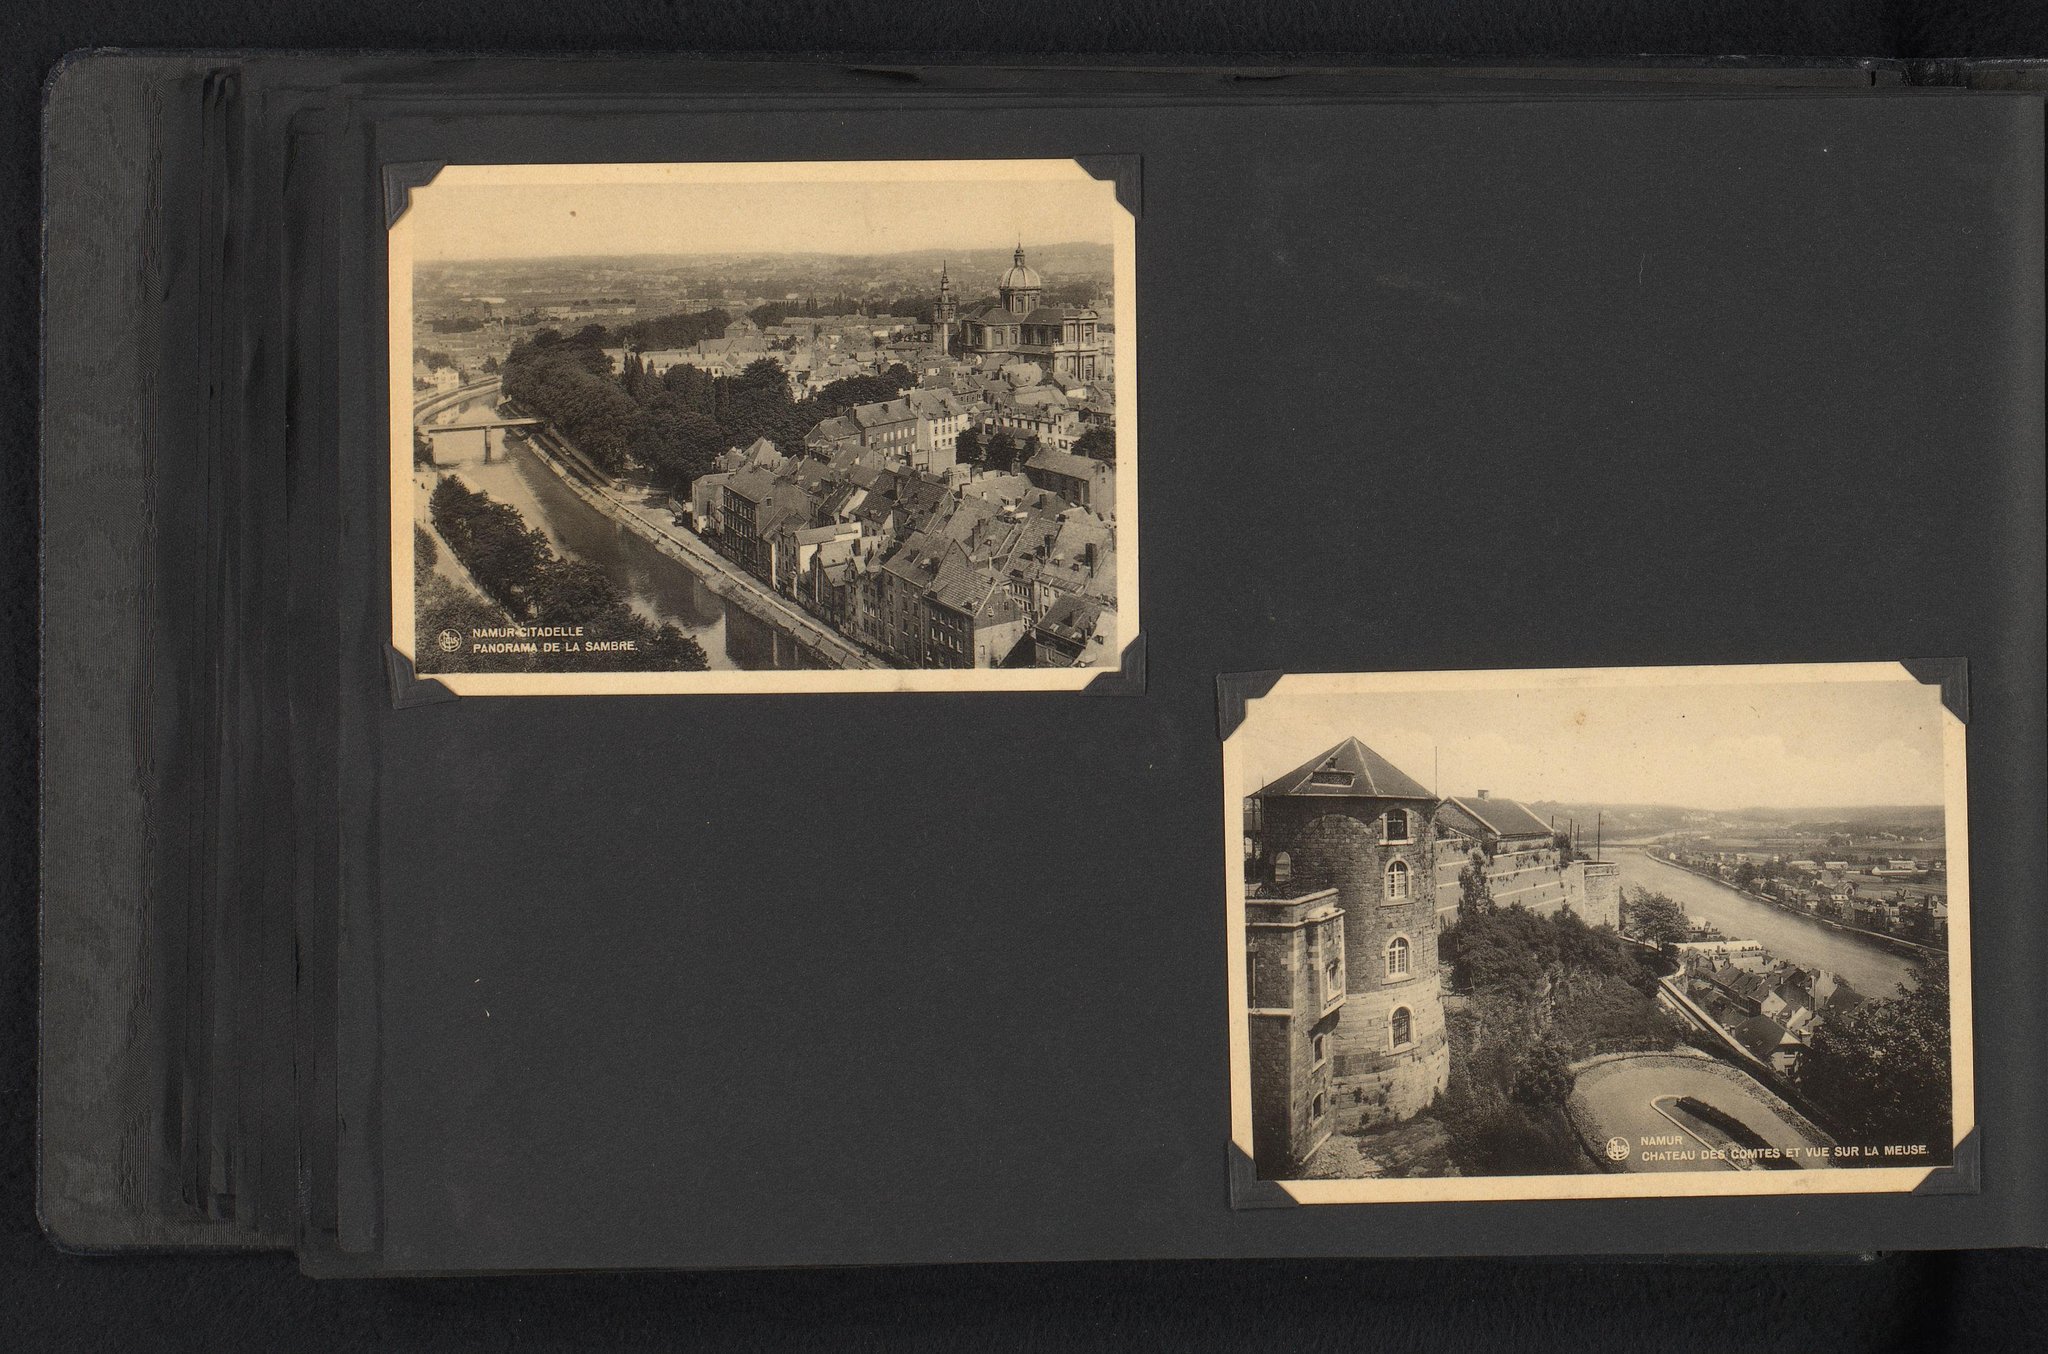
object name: album leaf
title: Twee fotomechanische prentbriefkaarten van Namen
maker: Anonymous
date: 1908-1934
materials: cardboard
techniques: photograph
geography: brussels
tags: city-view in general; 'veduta', castle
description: Deze prenten maken deel uit van een album.